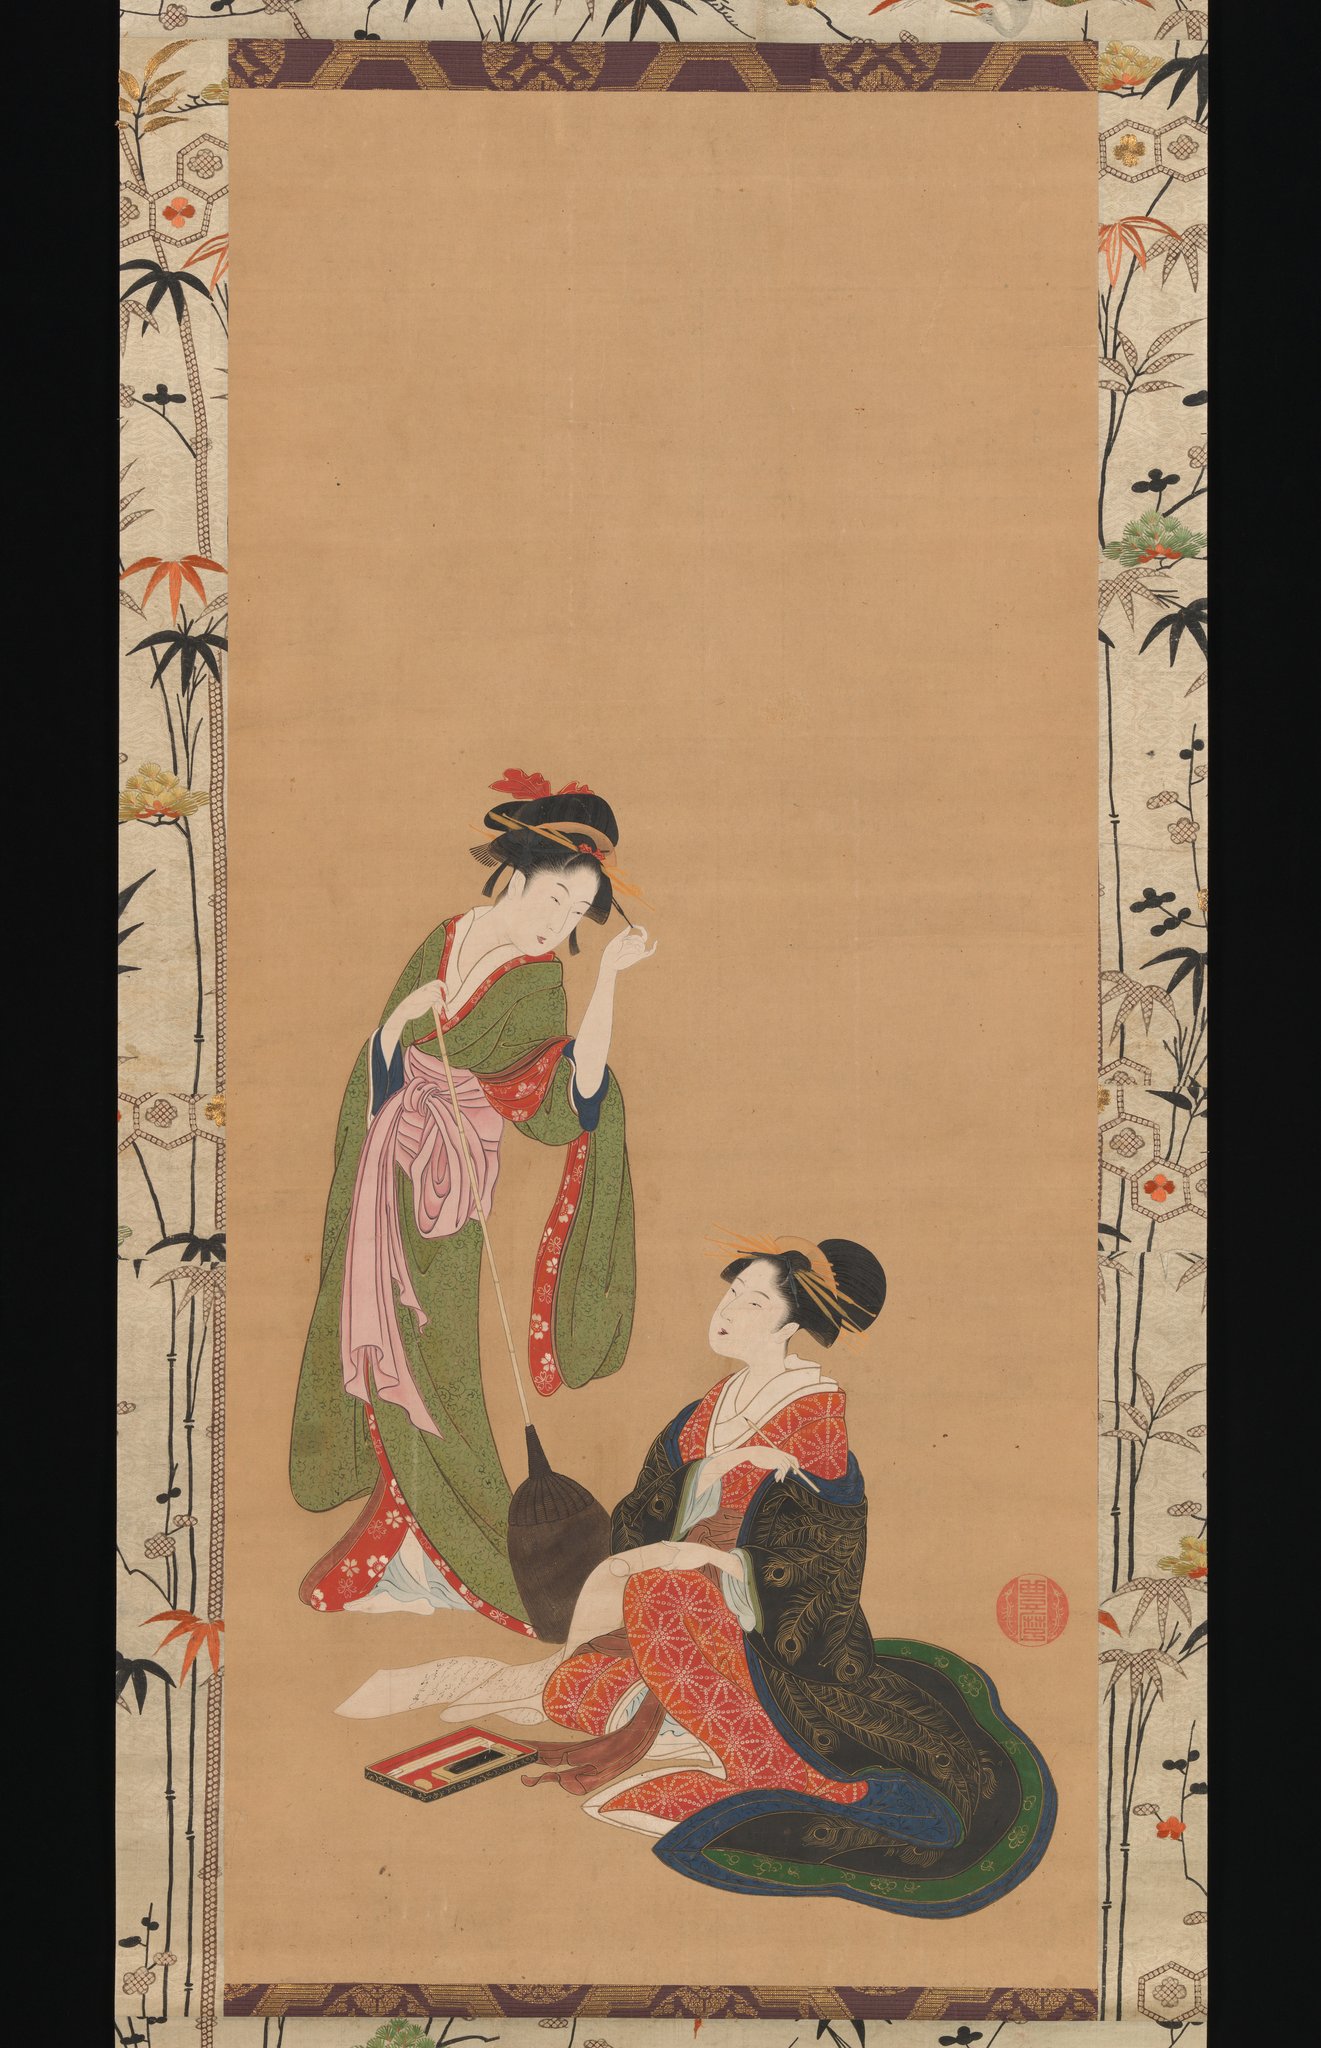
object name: hanging scroll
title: Courtesans Parodying Kanzan and Jittoku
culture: japanese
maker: kinpūsha toyomaro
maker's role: artist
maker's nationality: japanese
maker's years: 1800-1833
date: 1767-1833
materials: gold, ink, paper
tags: scrolls,women